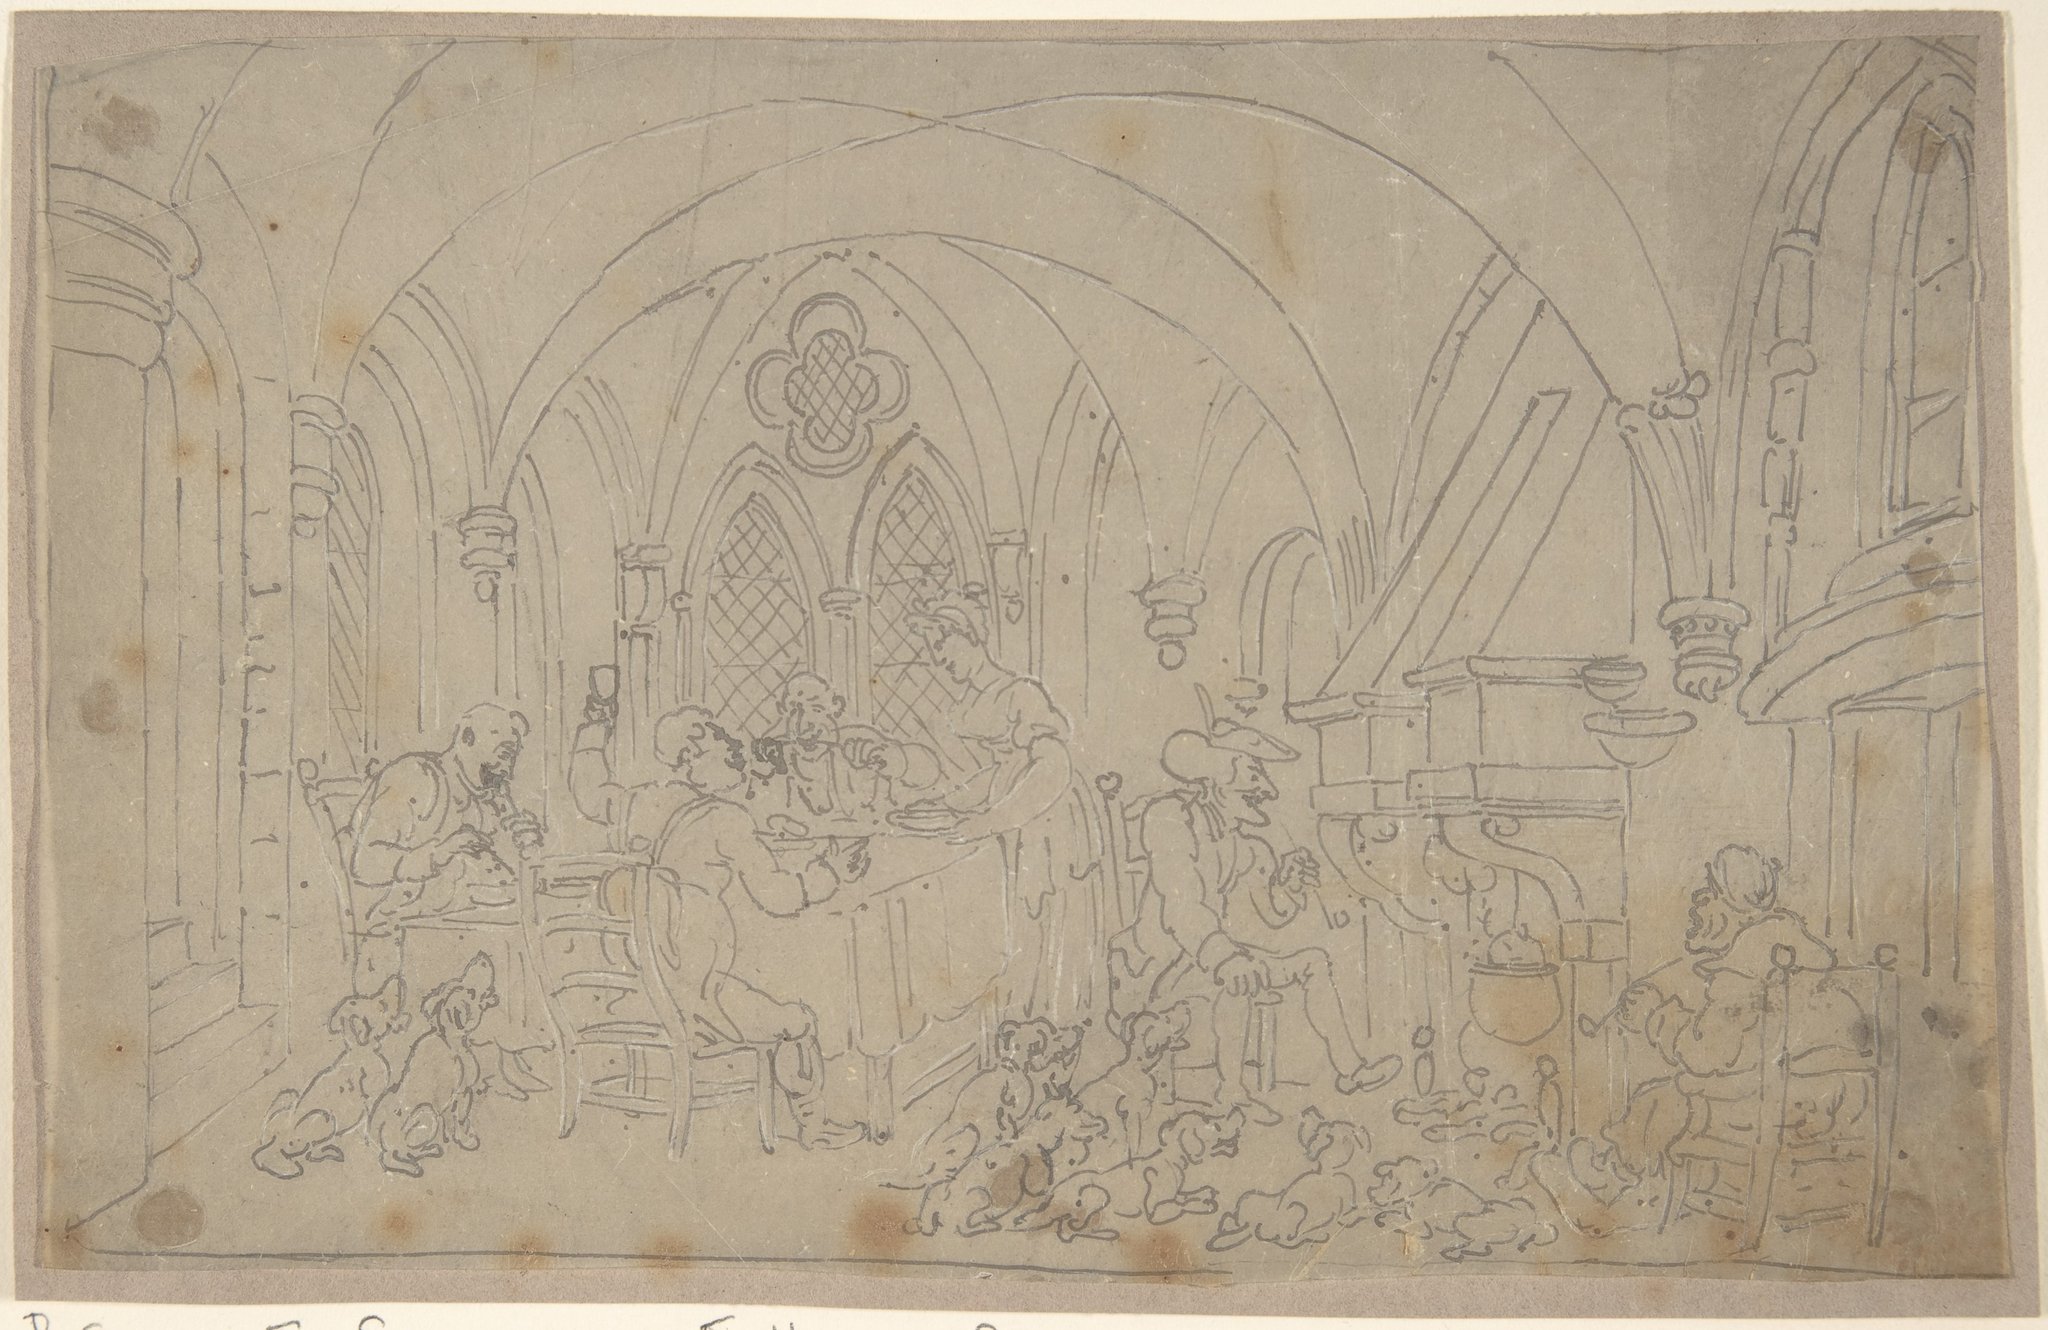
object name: drawing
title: Dr. Syntax and the Superannuated Fox Hunters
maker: thomas rowlandson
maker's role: artist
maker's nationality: british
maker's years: 1757-1827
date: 1820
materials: graphite, paper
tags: men,women,dogs